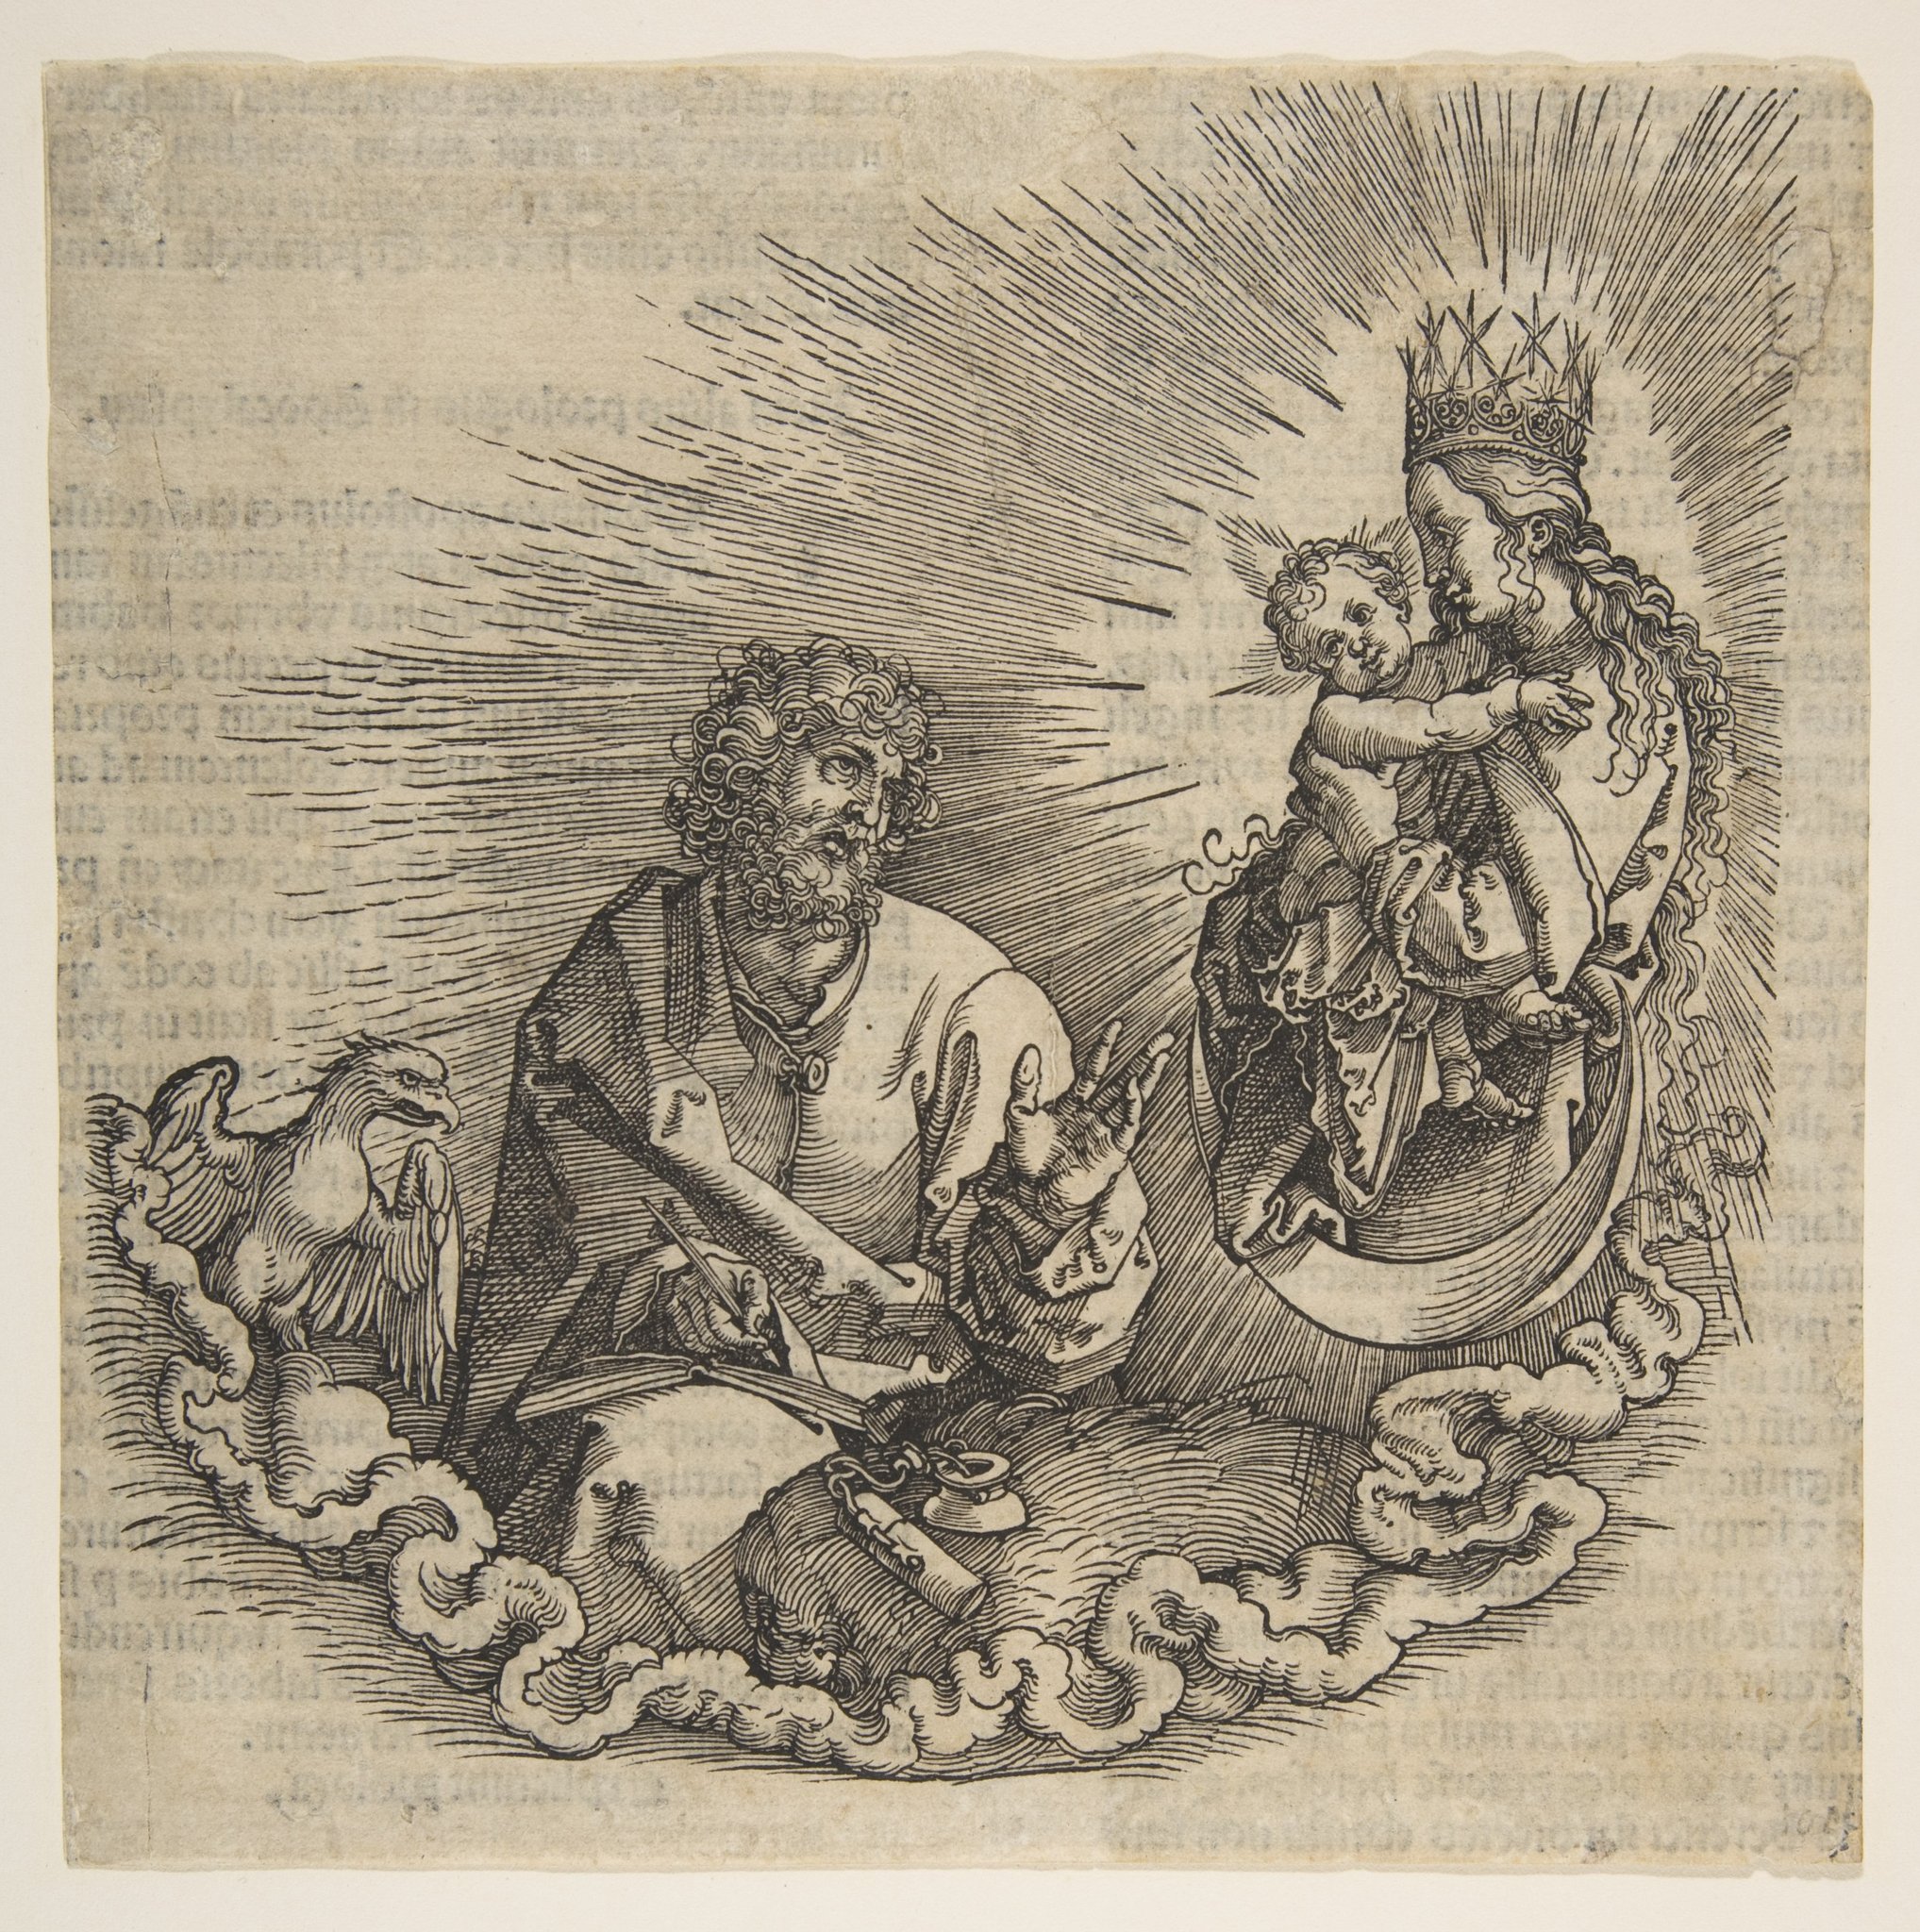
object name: print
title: The Virgin Appearing to Saint John, frontispiece to "The Apocalypse"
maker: albrecht dürer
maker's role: artist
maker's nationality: german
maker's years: 1471-1528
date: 1511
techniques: woodcut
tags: eagles,madonna and child,saint john the evangelist,writing